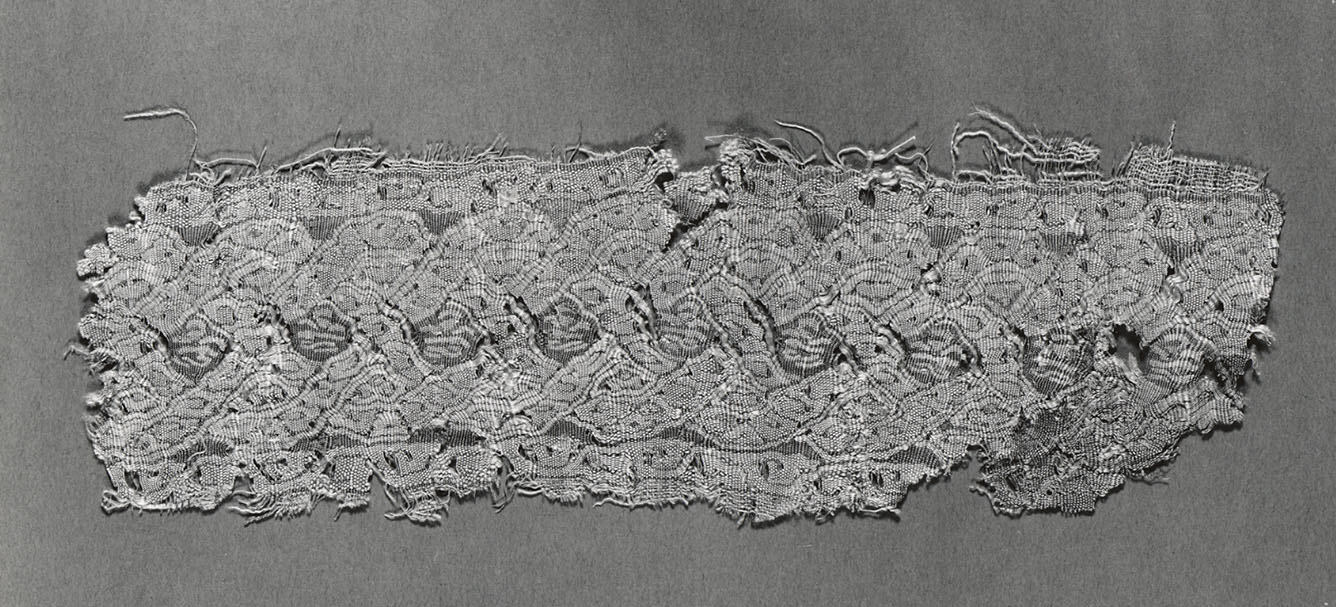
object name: textile fragment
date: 1001-1200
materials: silk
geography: egypt